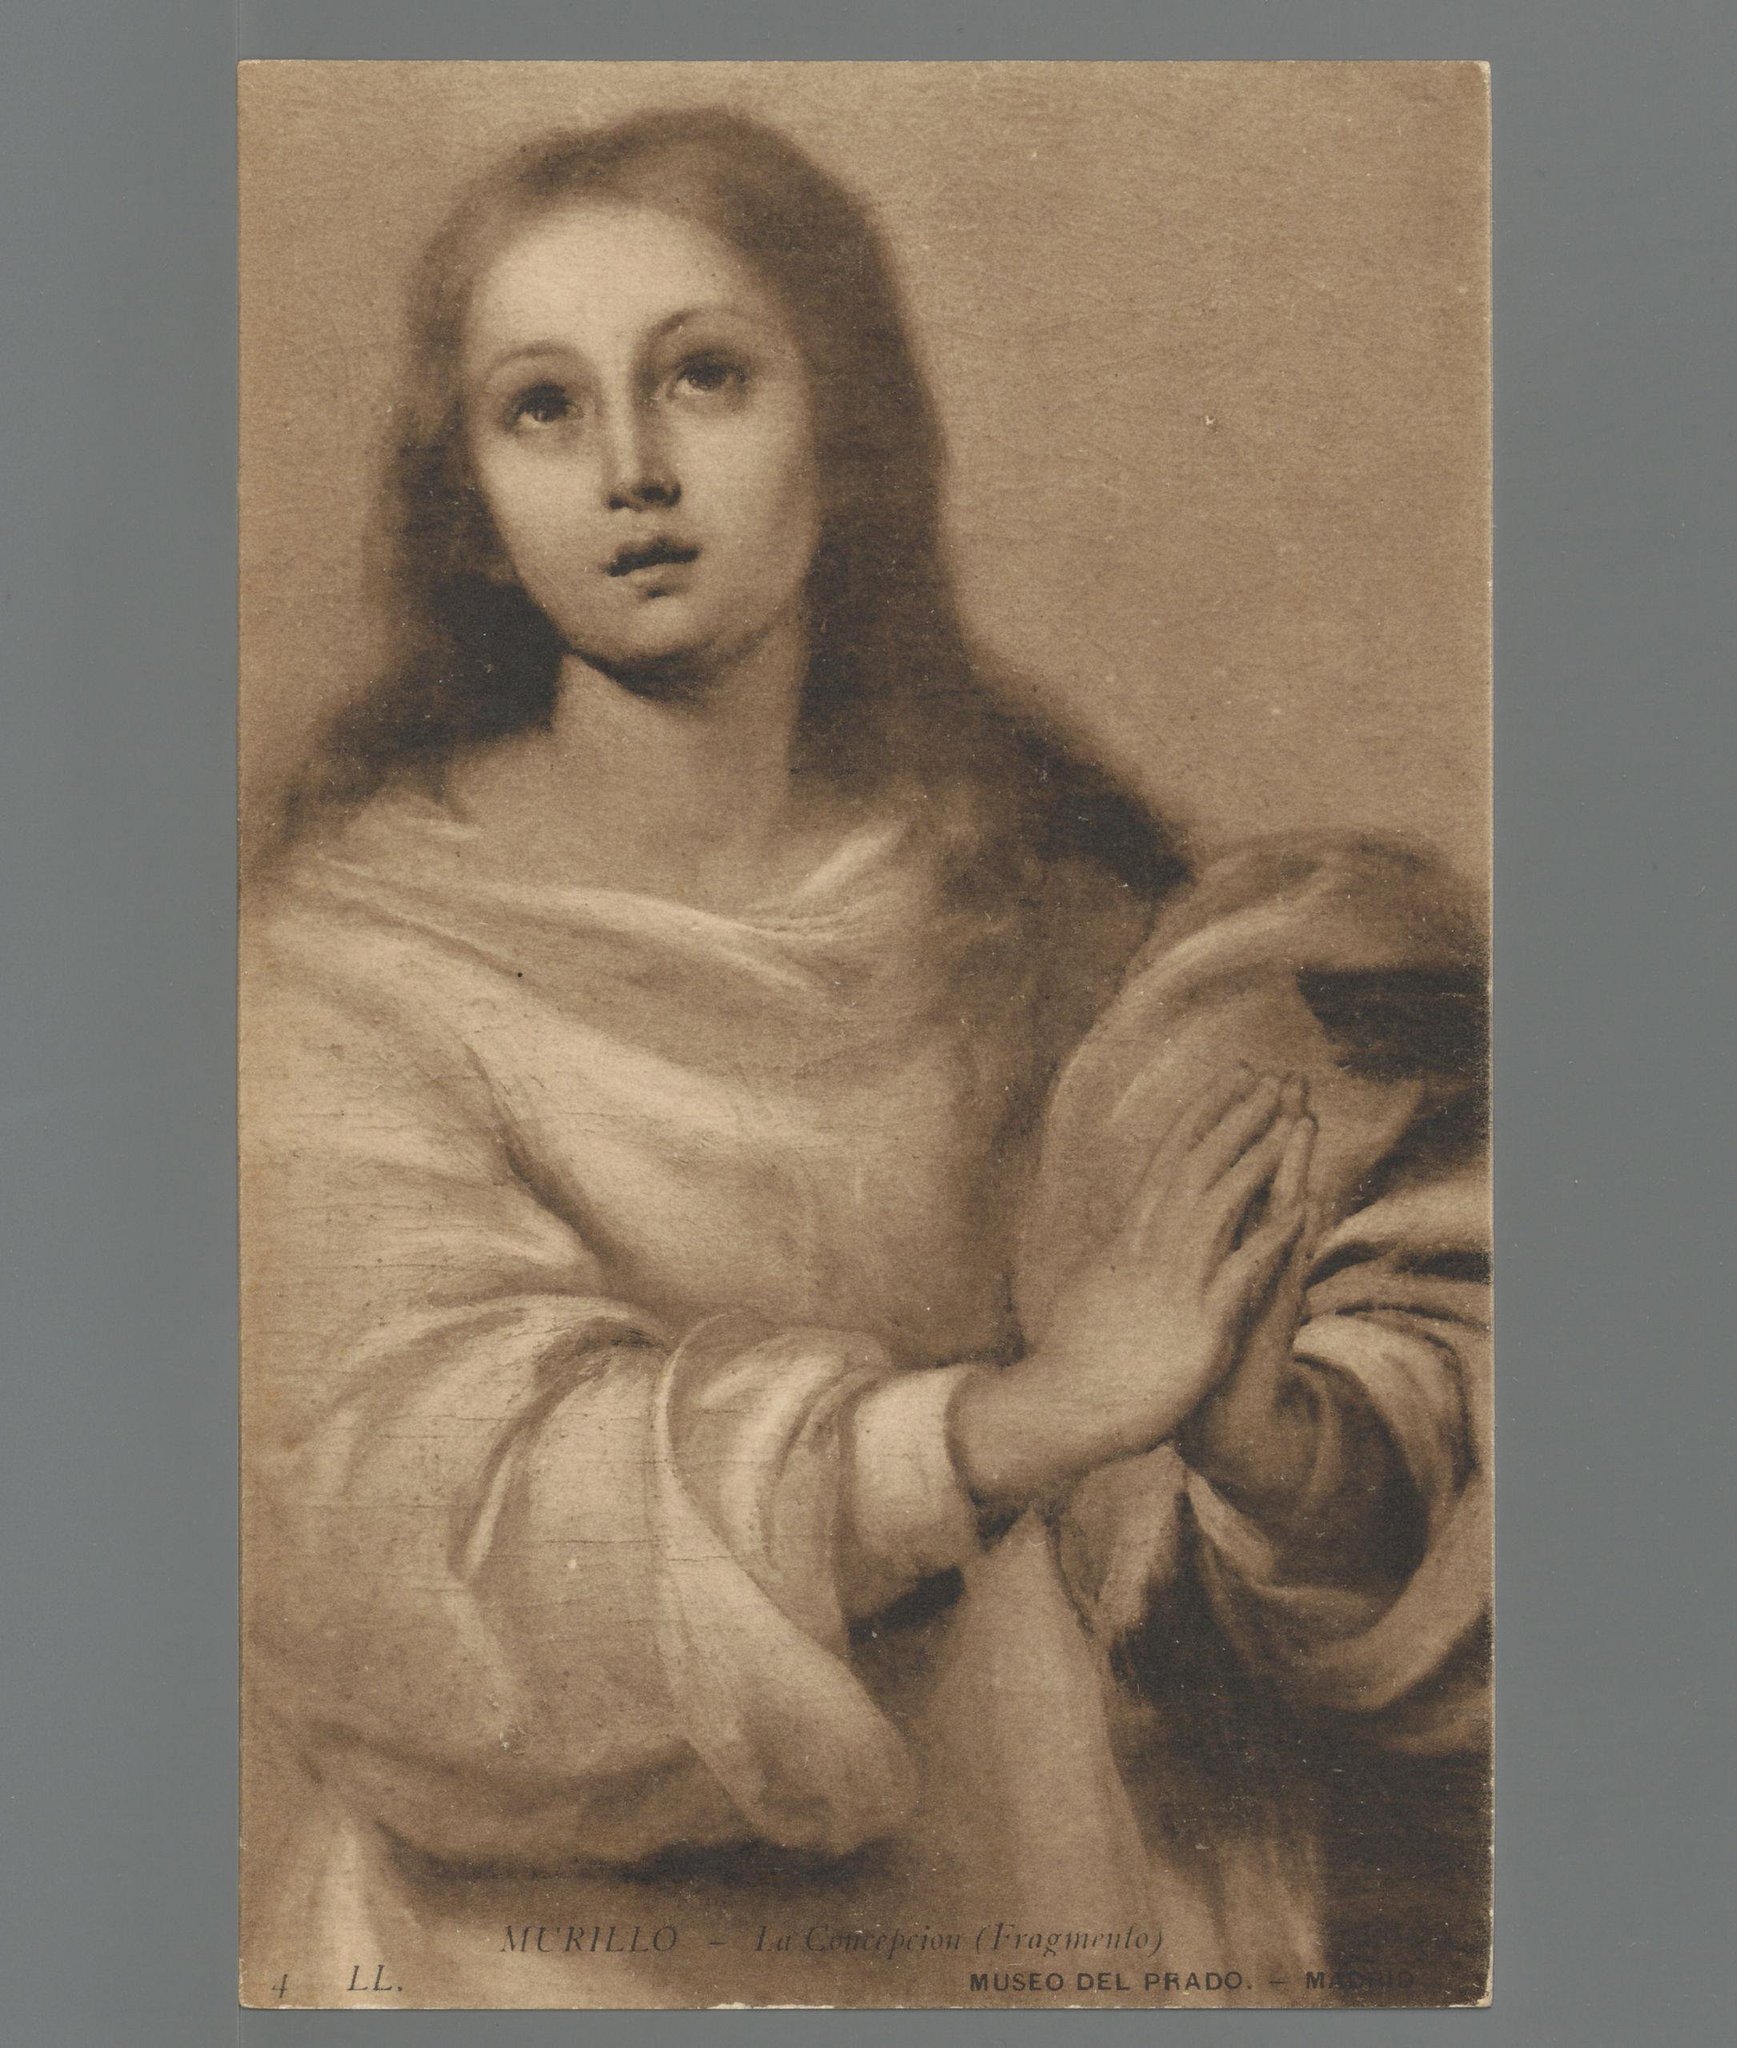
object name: ansichtkaart, prentbriefkaart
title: La Concepcion (Fragmento)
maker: bartolomé esteban murillo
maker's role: draughtsman, painter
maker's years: 1617-1682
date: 1905-1920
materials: cardboard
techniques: photograph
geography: madrid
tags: mary (without the christ-child)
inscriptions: collector's mark: ‘AFE v S’